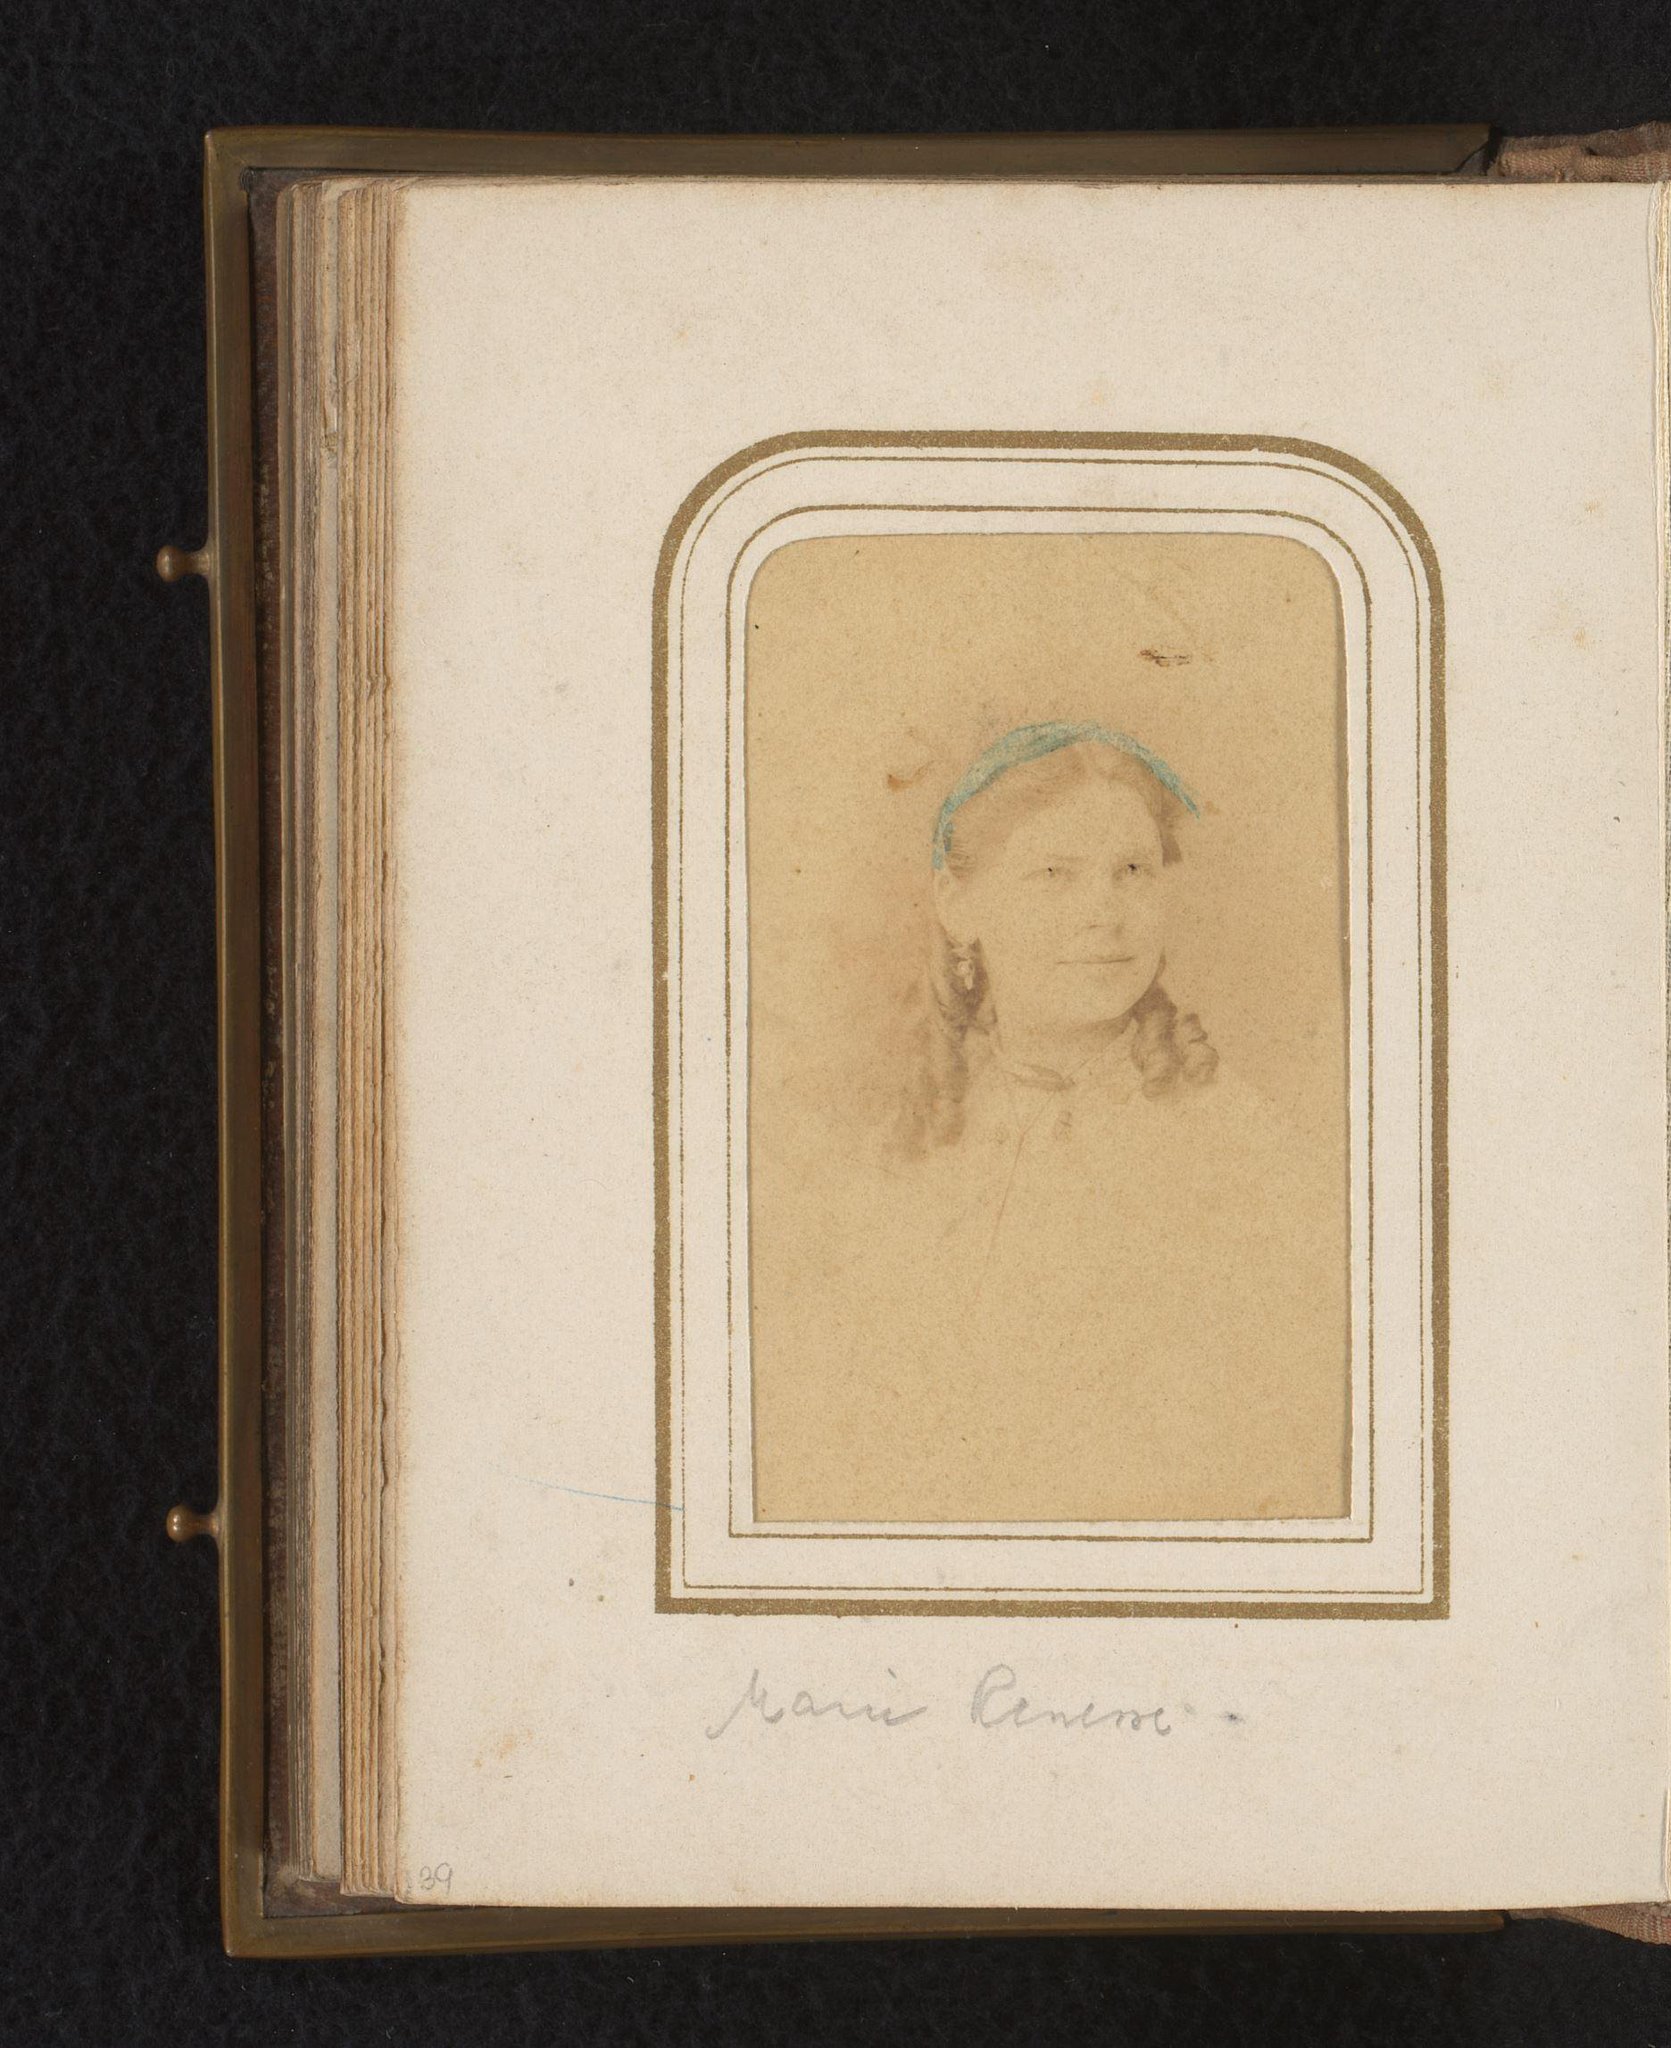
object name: album leaf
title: Portret van een jonge vrouw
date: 1848-1878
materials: cardboard, photographic support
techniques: albumen print, hand coloring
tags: adolescent, young woman, maiden, historical persons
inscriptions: annotation: ‘[...]’, annotation: ‘[...]’, inscription: ‘Steinberger & Bauer/ Junchofstrasse No. 10./ Frankfurt a/M.’